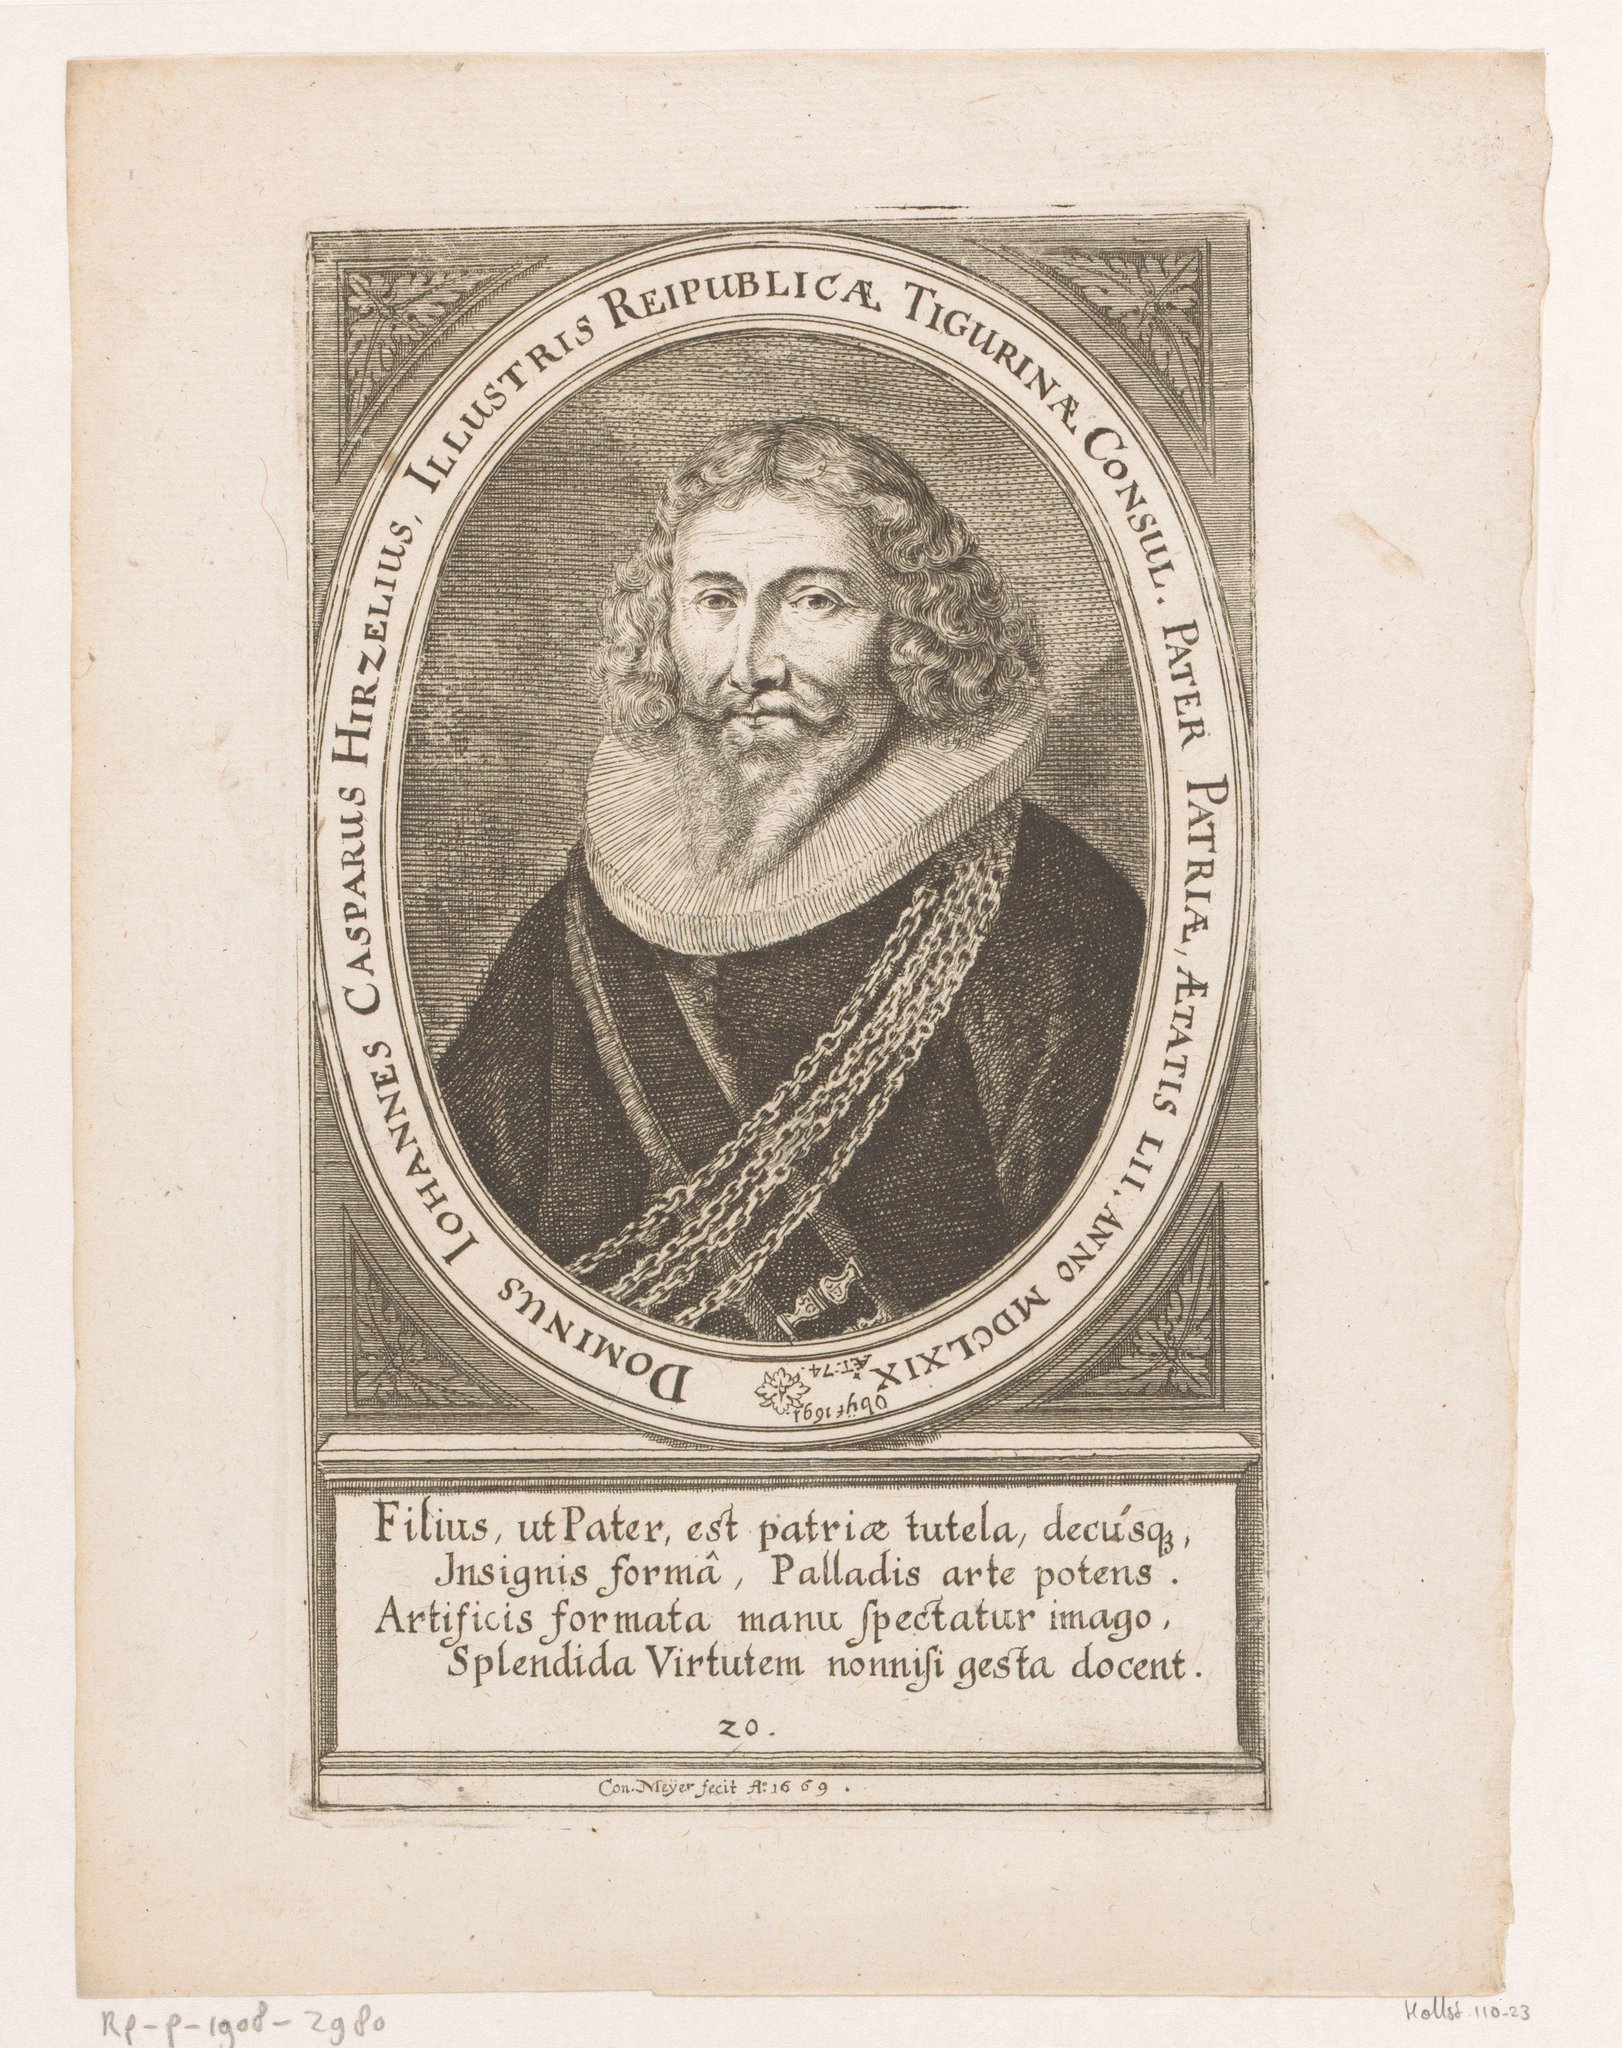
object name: print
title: Portret van Hans Caspar Hirzel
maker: conrad meyer (i)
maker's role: painter, print maker, publisher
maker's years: 1618-1689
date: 1669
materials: paper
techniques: engraving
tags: mayor, burgomaster, other non-personal regalia, e.g. mayor chain, historical persons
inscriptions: collector's mark: Lugt 2228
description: Onderdeel van een serie van 67(?) portretten van burgemeesters van Zürich. Zie Hollstein German 110, 1-26.